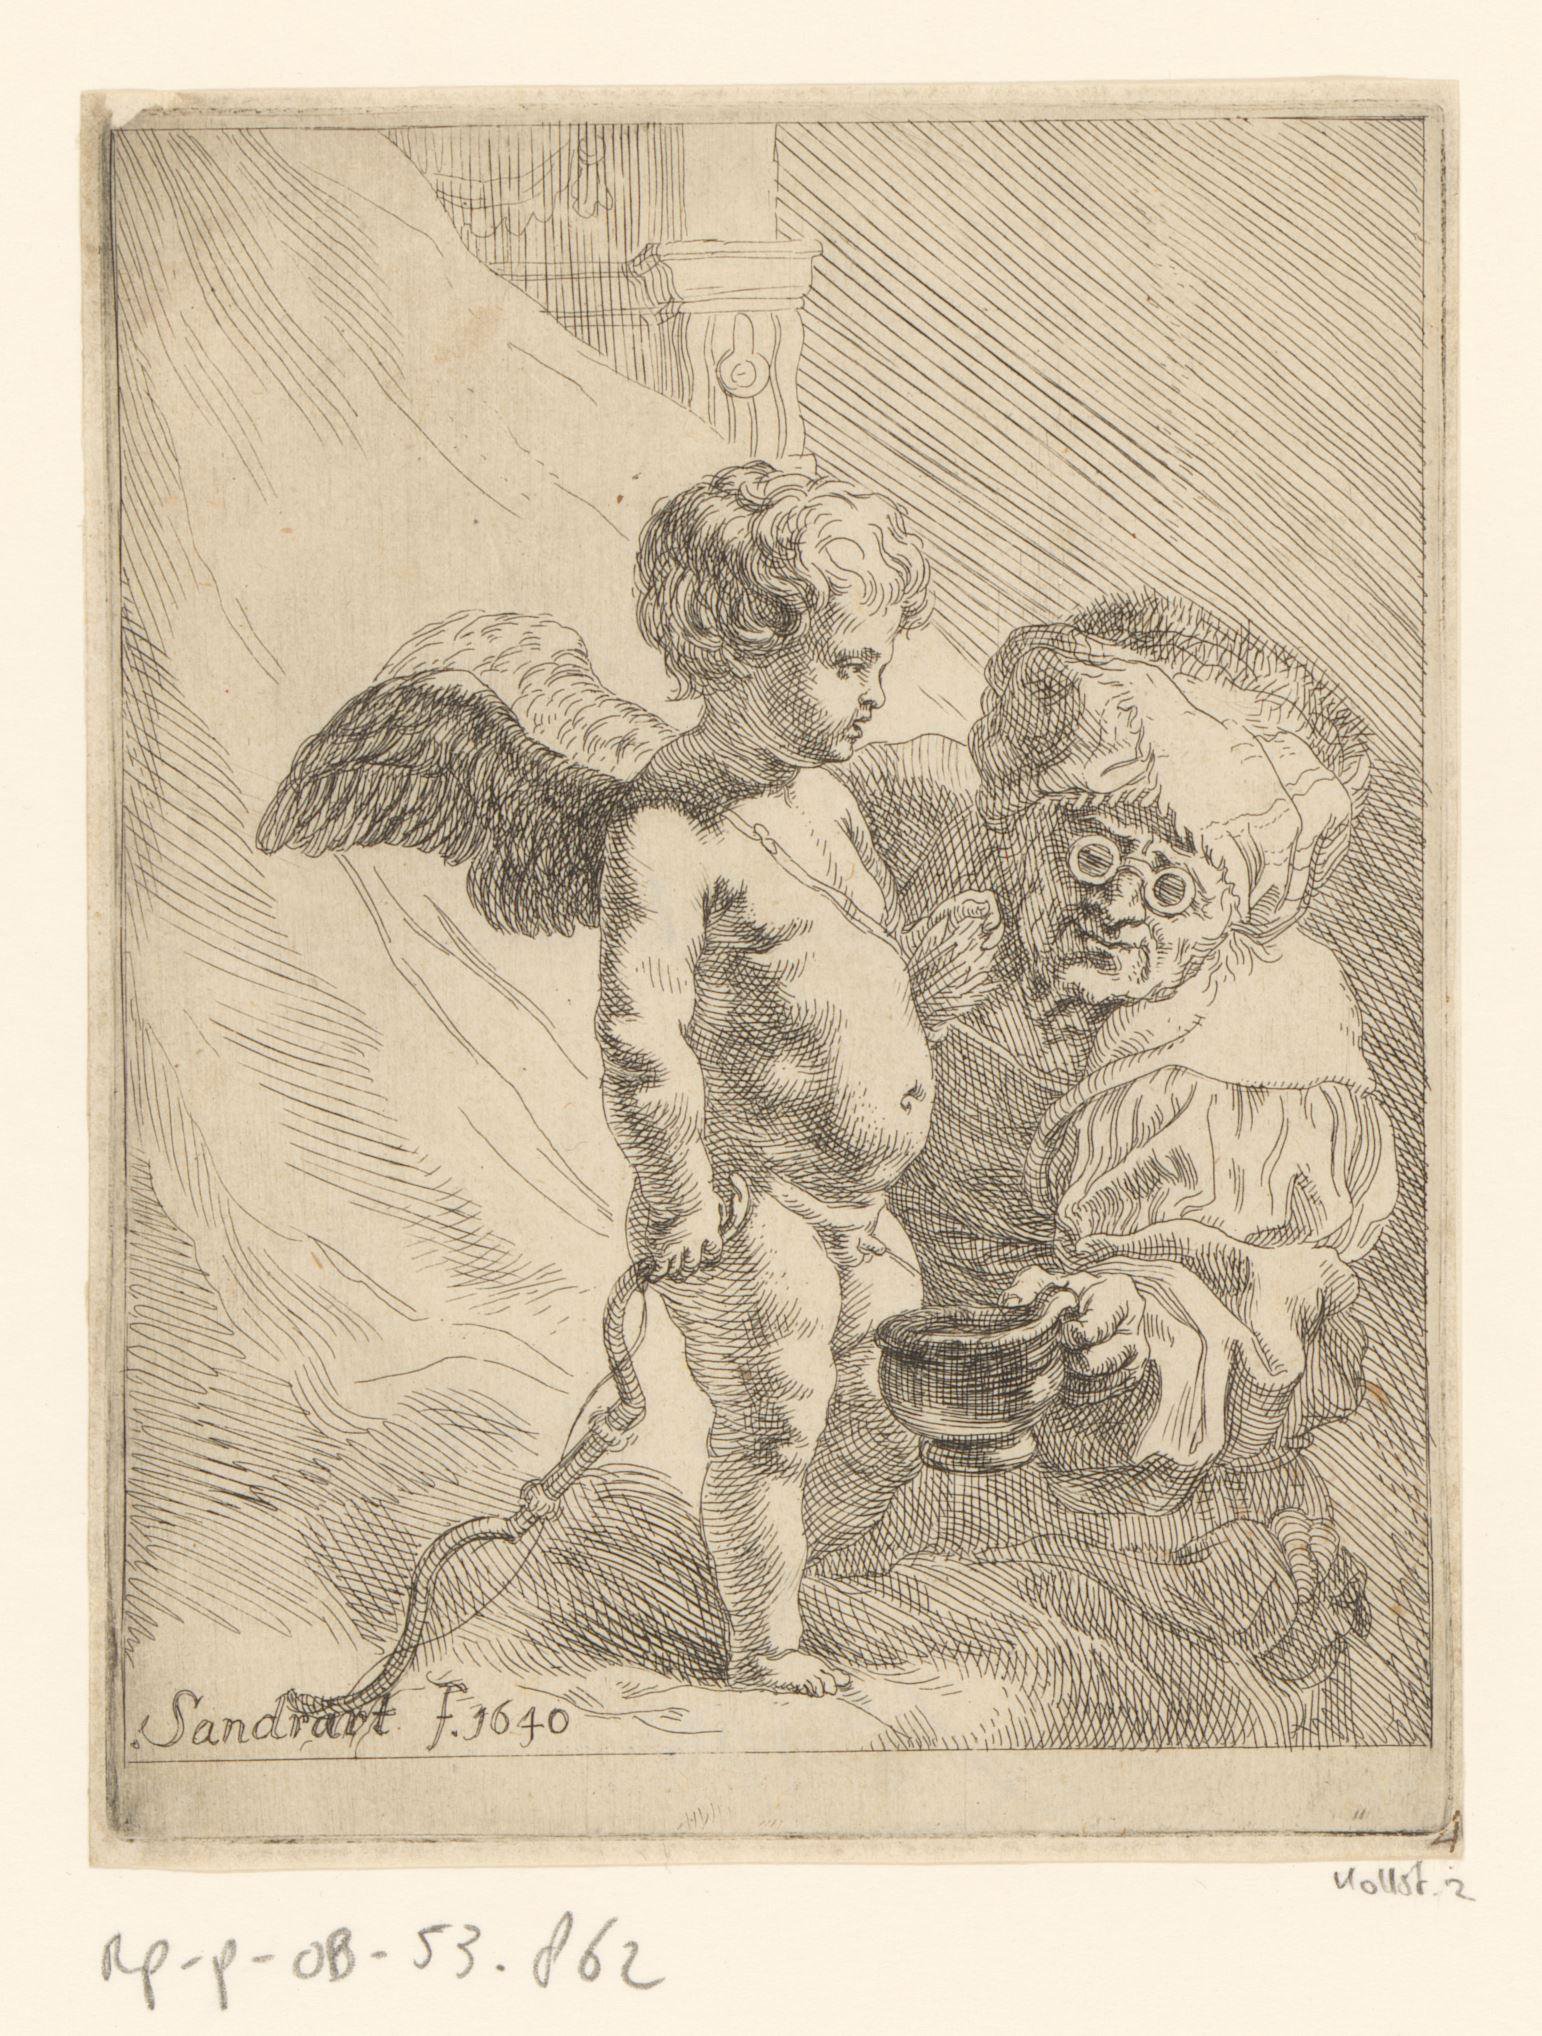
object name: print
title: Plas van Cupido wordt door een oude man opgevangen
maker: joachim von sandrart (i)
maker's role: draughtsman, painter, print maker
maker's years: 1606-1688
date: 1640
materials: paper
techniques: etching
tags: old man, (story of) cupid, amor (eros), chamber-pot, urination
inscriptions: collector's mark: Lugt 240